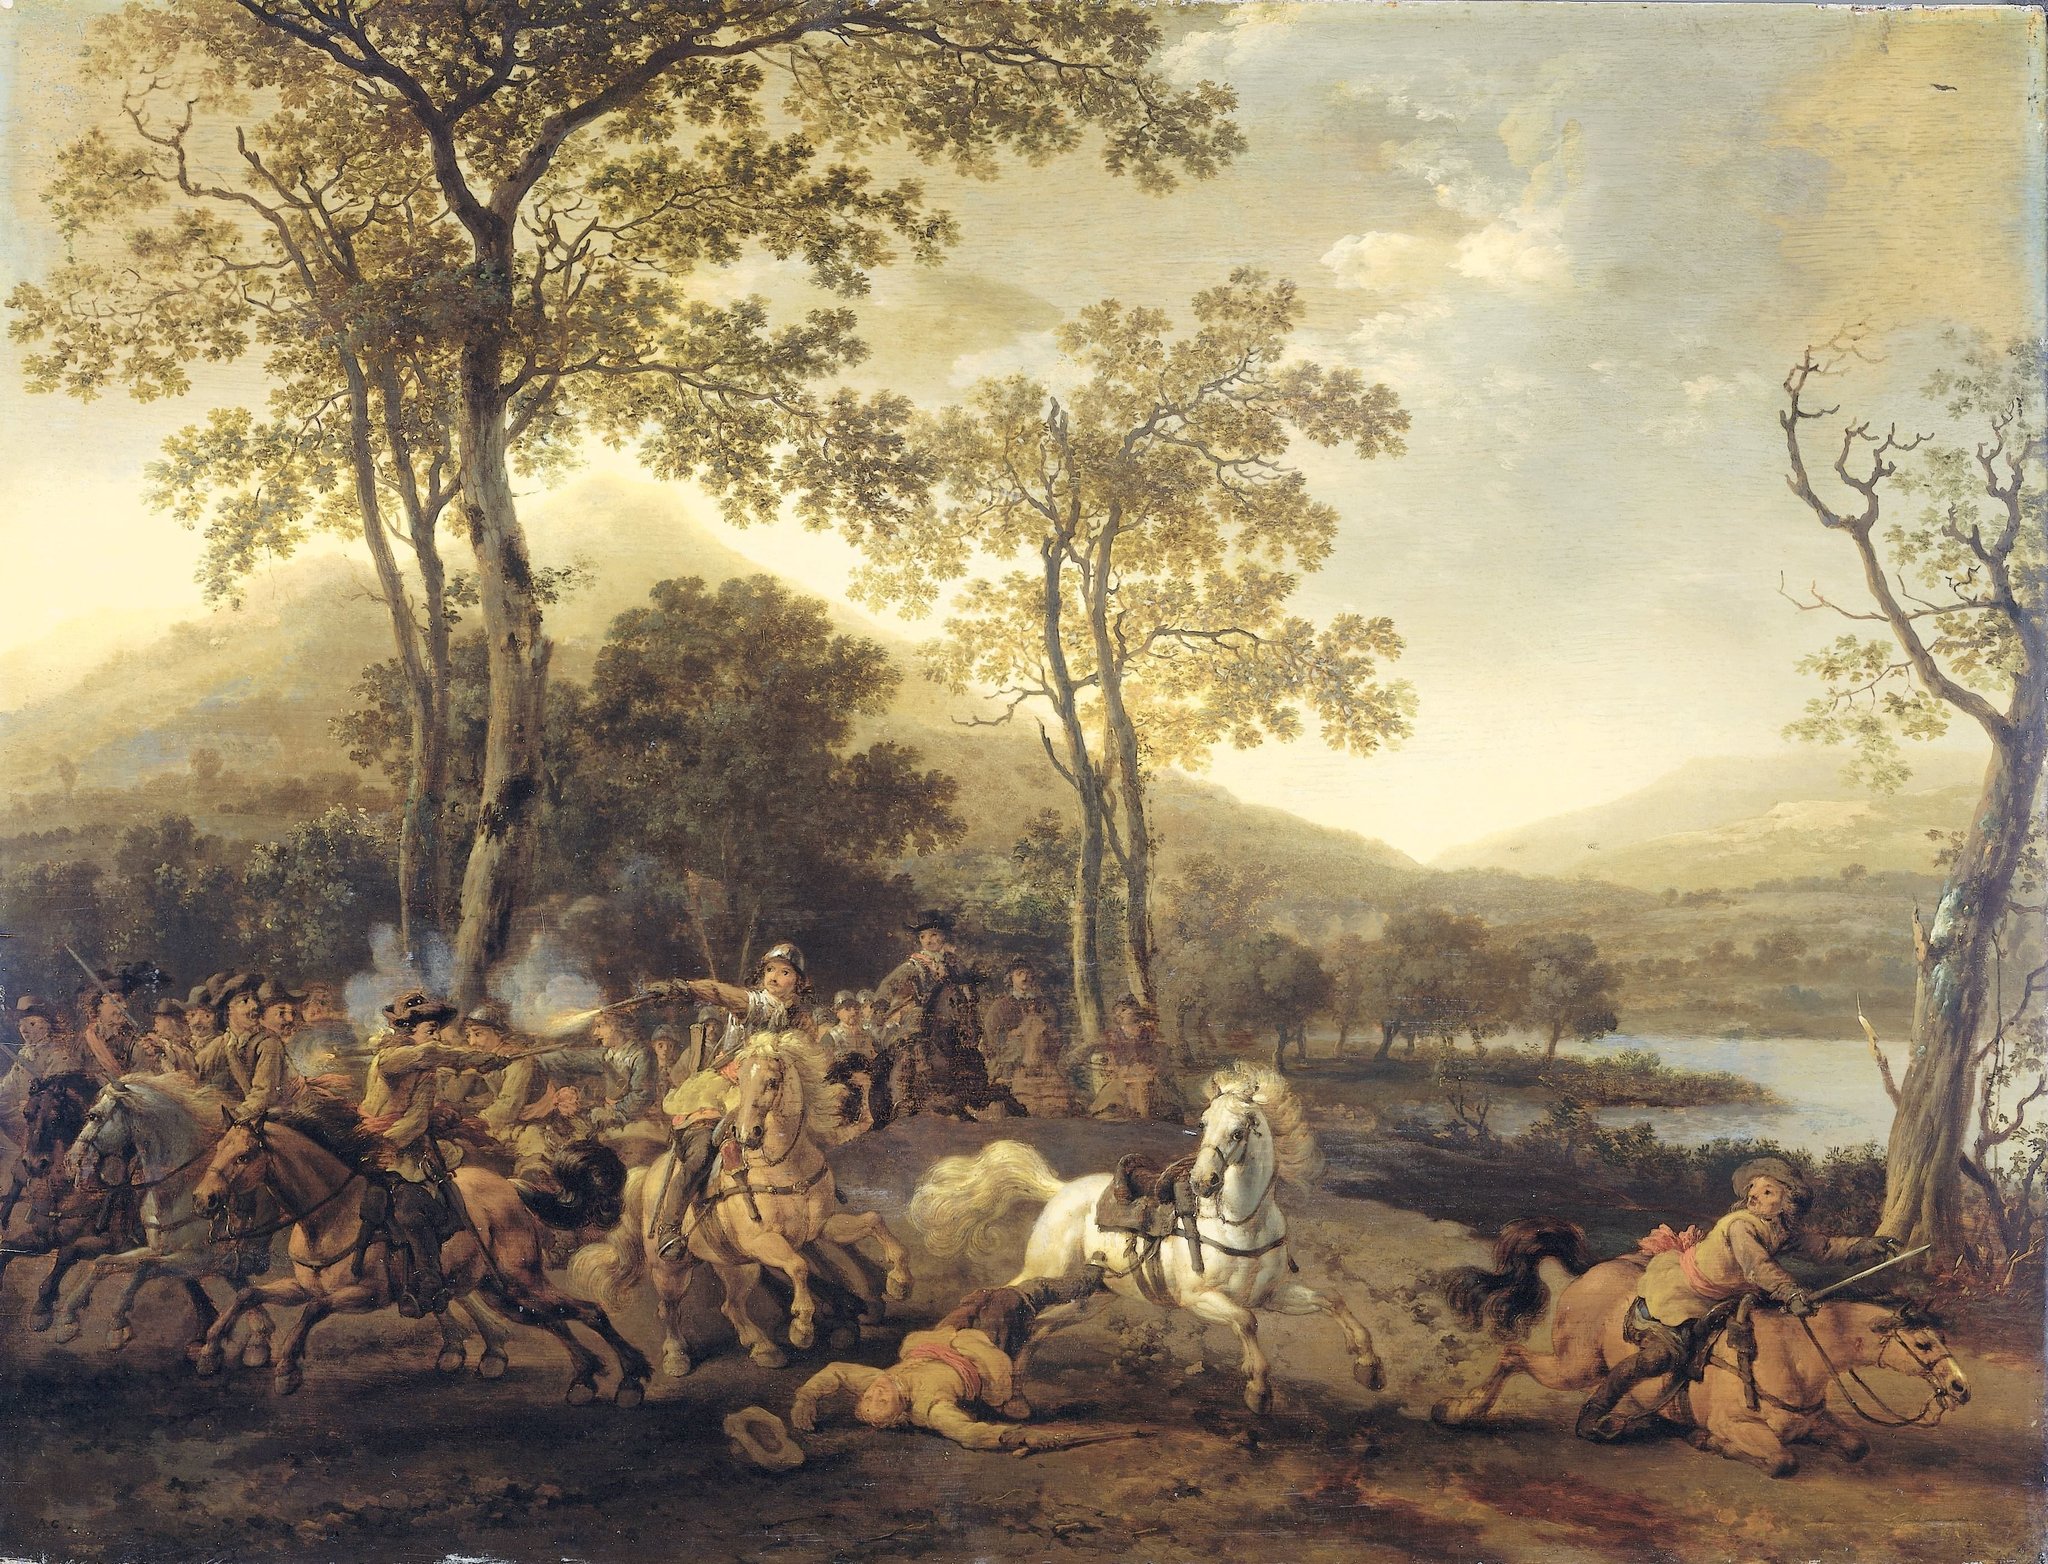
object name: painting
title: Cavalry Skirmish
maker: abraham van calraet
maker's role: painter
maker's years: 1642-1722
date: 1660-1722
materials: oil, panel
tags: battle (+ cavalry, horsemen)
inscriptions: signature: ‘AC’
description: Landschap met een ruitergevecht. In een heuvellandschap bij de oever van een rivier beschieten twee groepen ruiters elkaar.